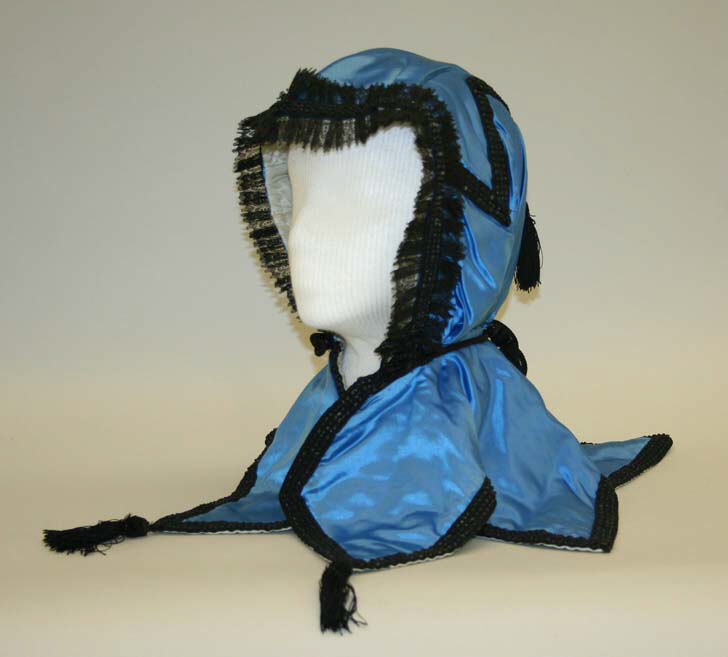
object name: hood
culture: american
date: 1860-1875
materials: cotton, silk